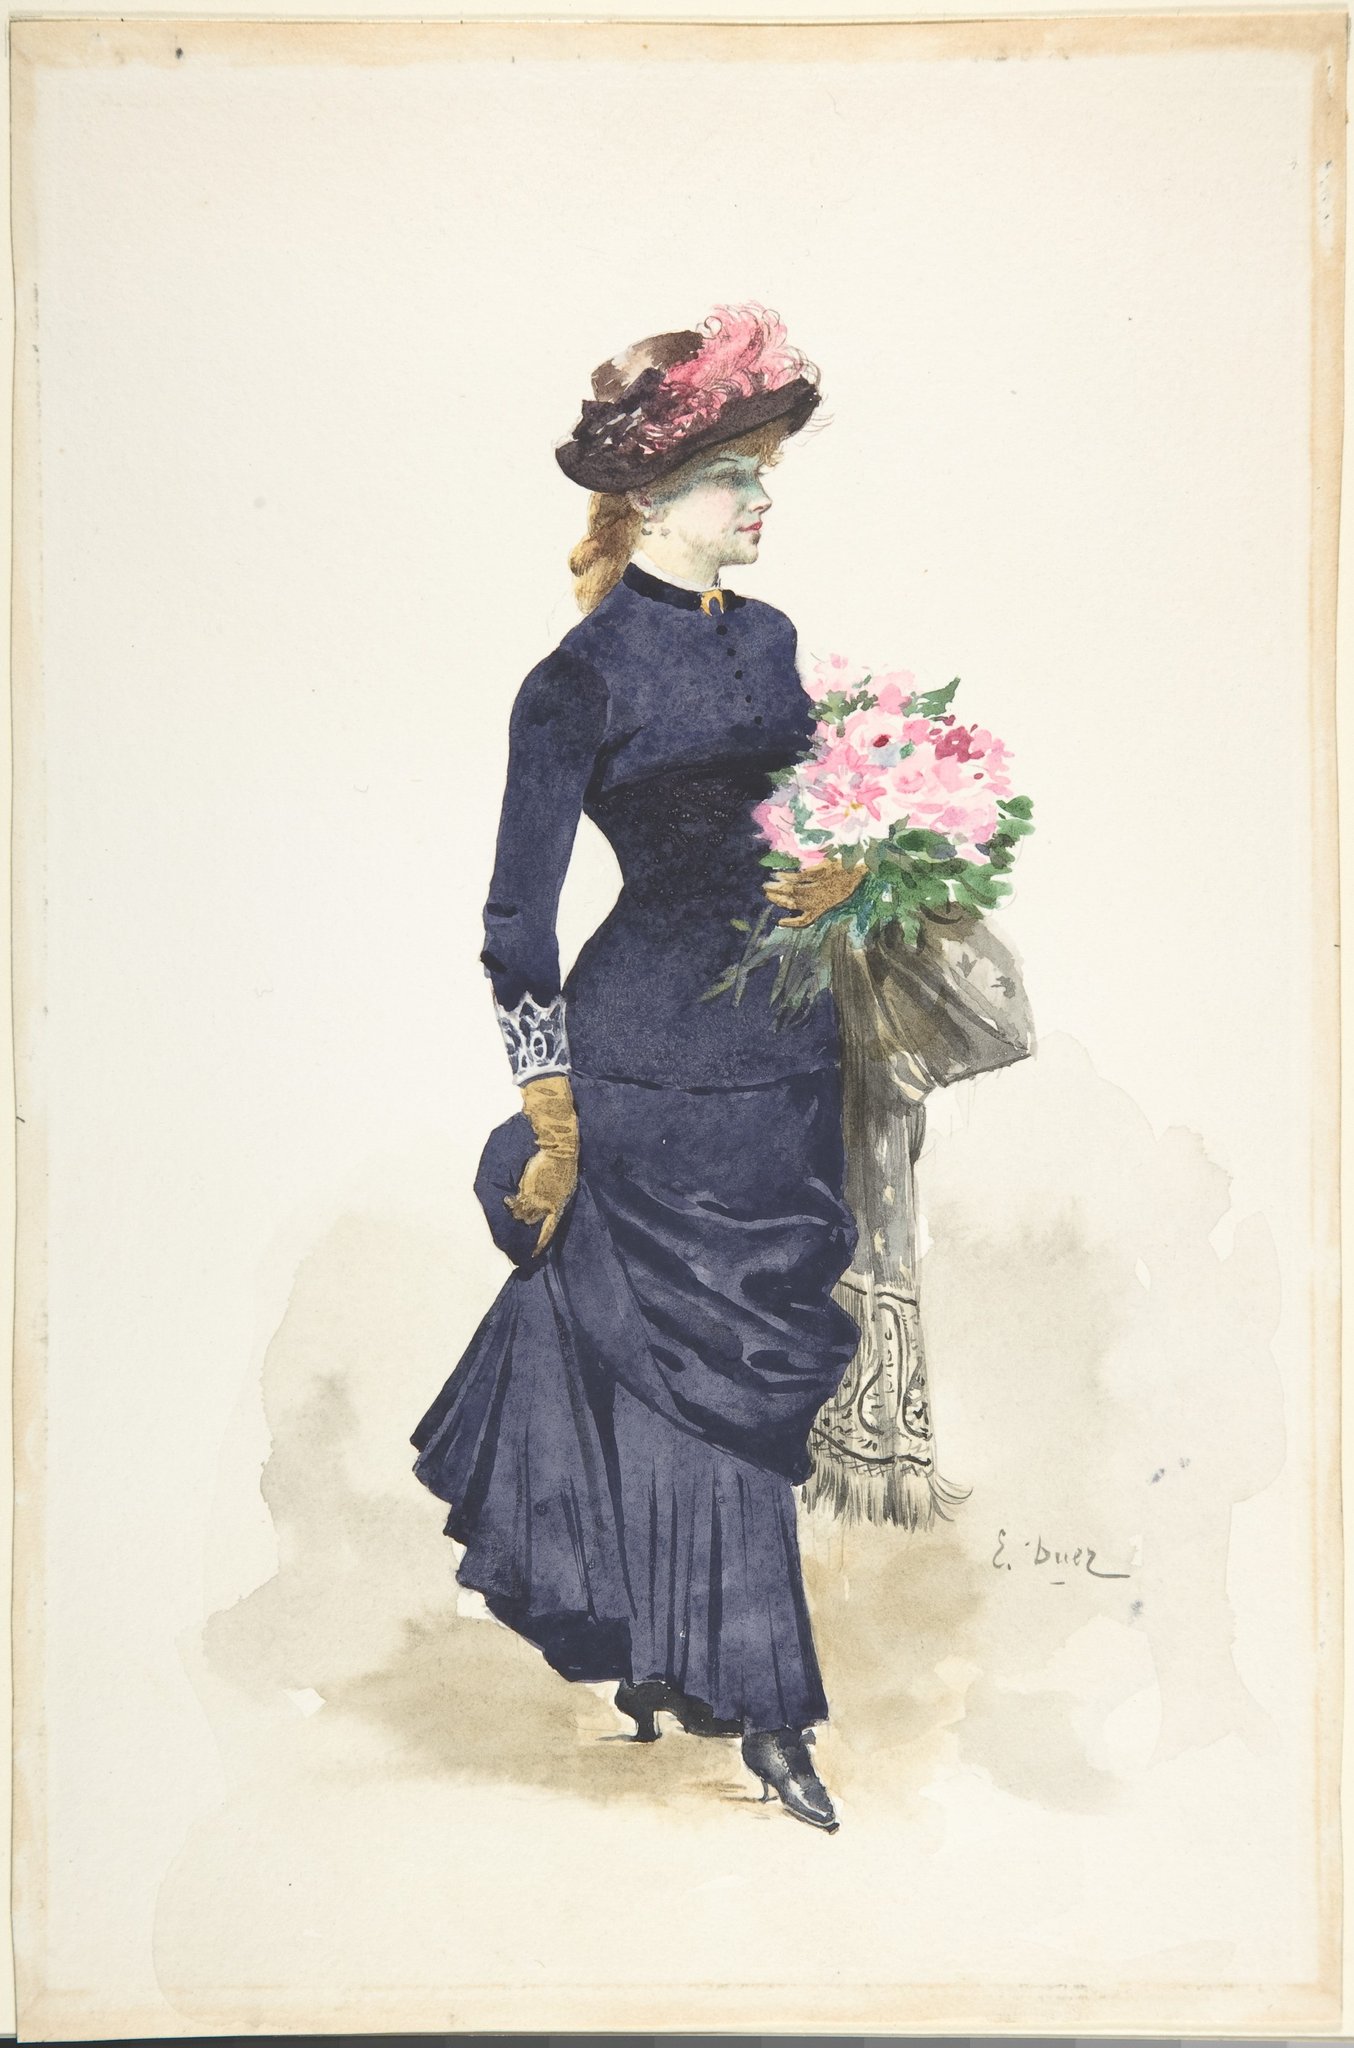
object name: drawing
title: The Bouquet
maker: ernest-ange duez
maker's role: draftsman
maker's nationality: french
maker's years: 1843-1896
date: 1893-1945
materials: watercolor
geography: france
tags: women,flowers